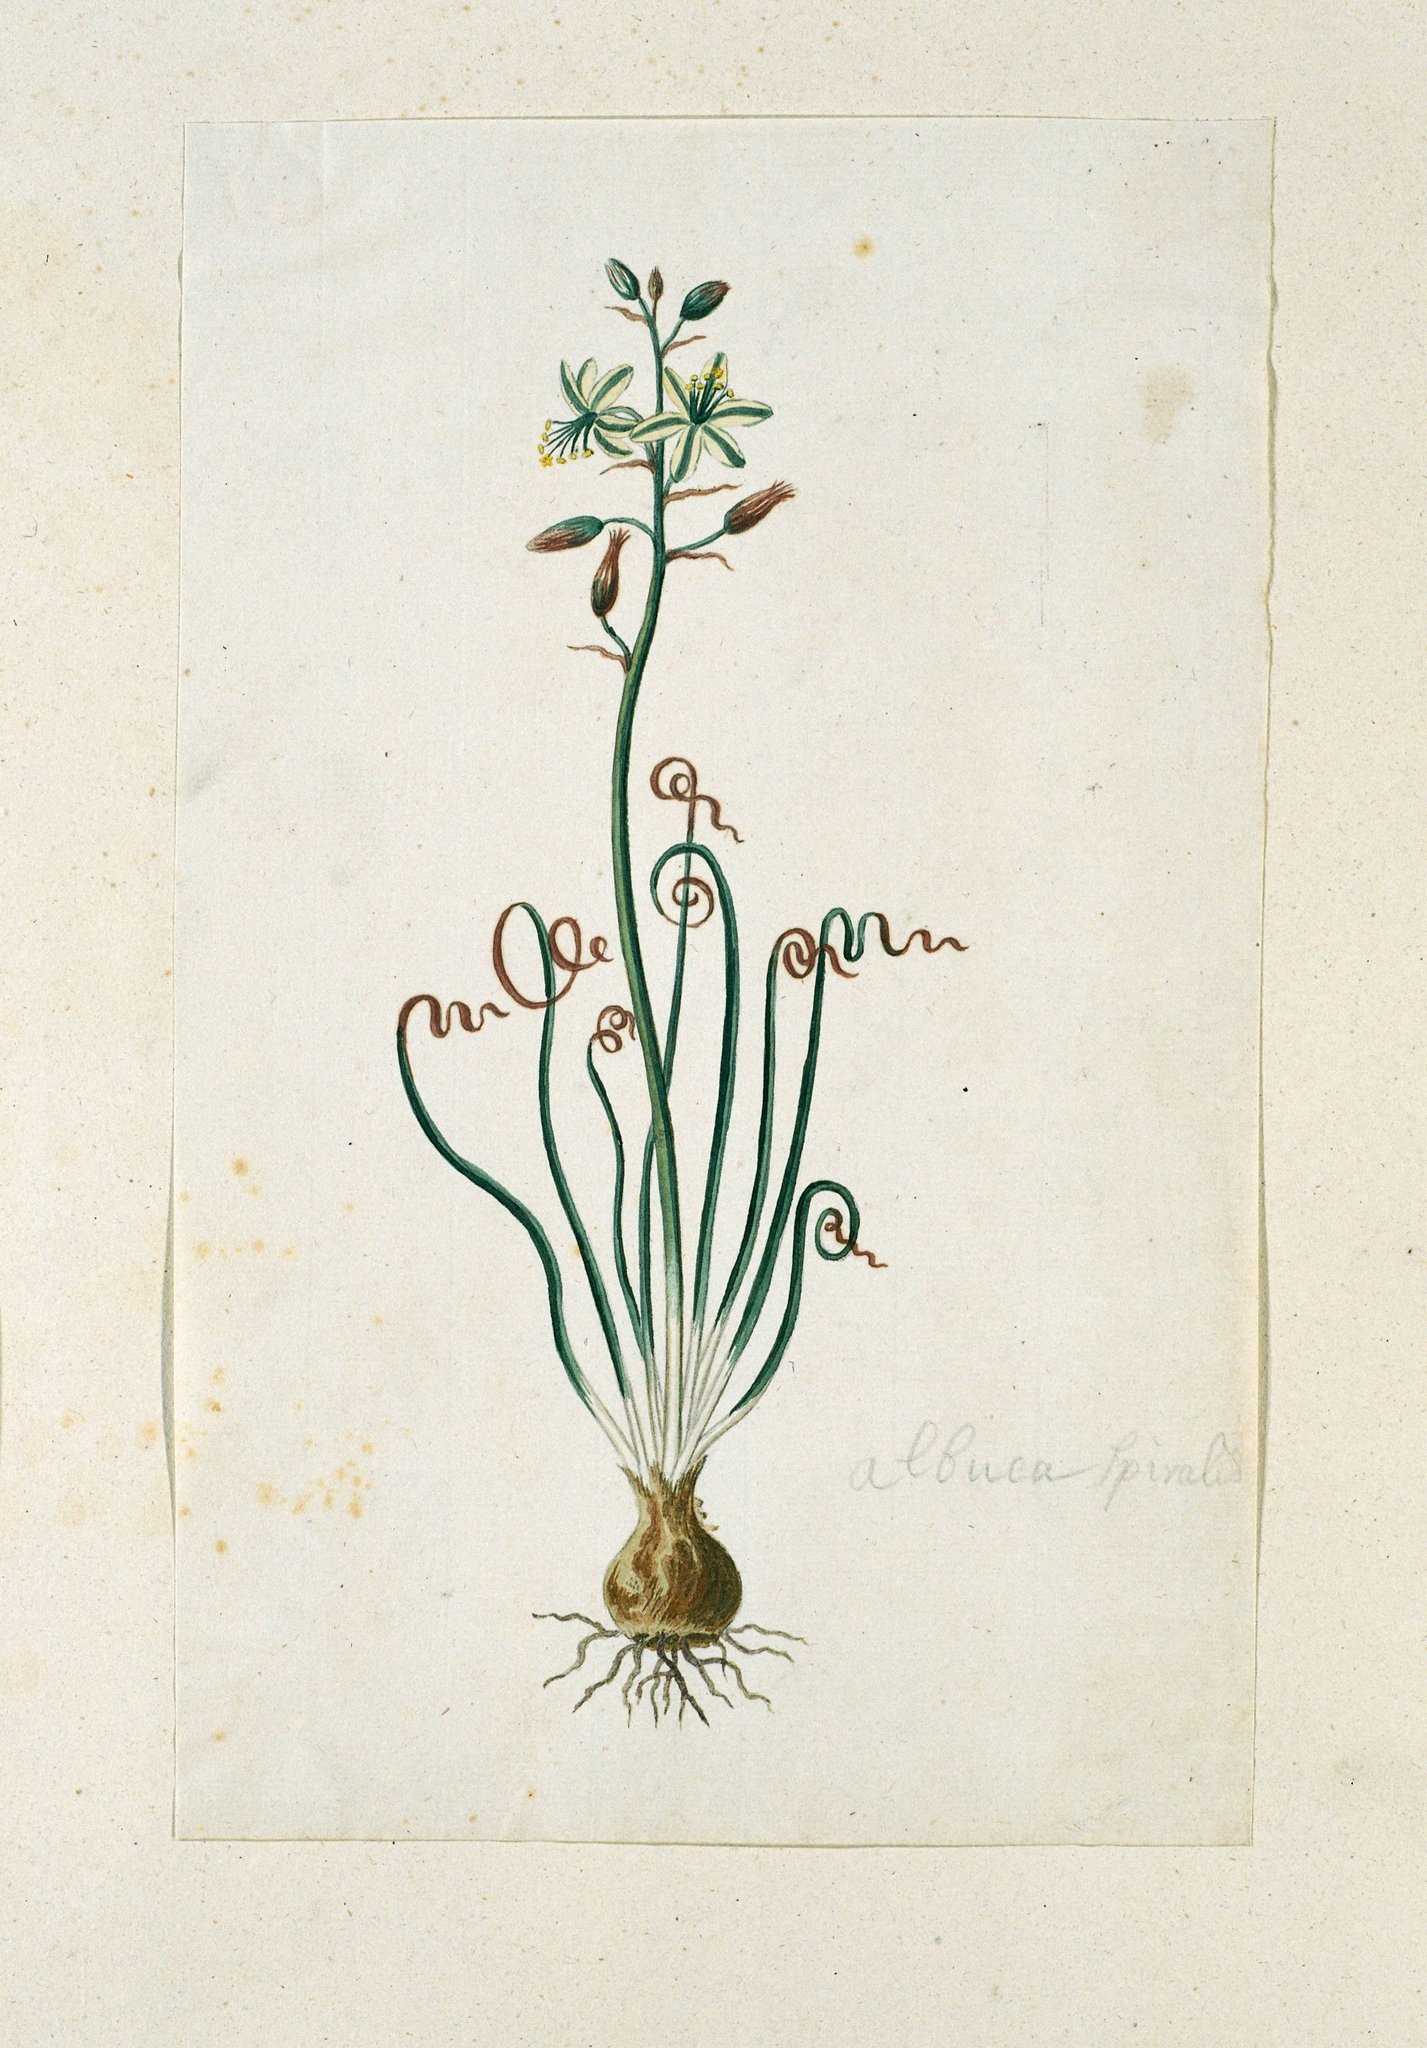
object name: album leaf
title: Ornithogalum polyphyllum Jacq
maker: robert jacob gordon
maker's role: draughtsman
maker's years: 1743-1795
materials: chalk, paper, pencil, watercolor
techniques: brush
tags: plants; vegetation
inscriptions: annotation: ‘albuca Spiralis’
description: De tekening is gemaakt voor of tijdens een van Gordon's vier expedities door de Kaapprovincie, van oktober 1777 tot maart 1786. Sommige (soort)namen kunnen zijn gewijzigd, gezien reorganisatie in plantentaxonomie gedurende de afgelopen jaren.